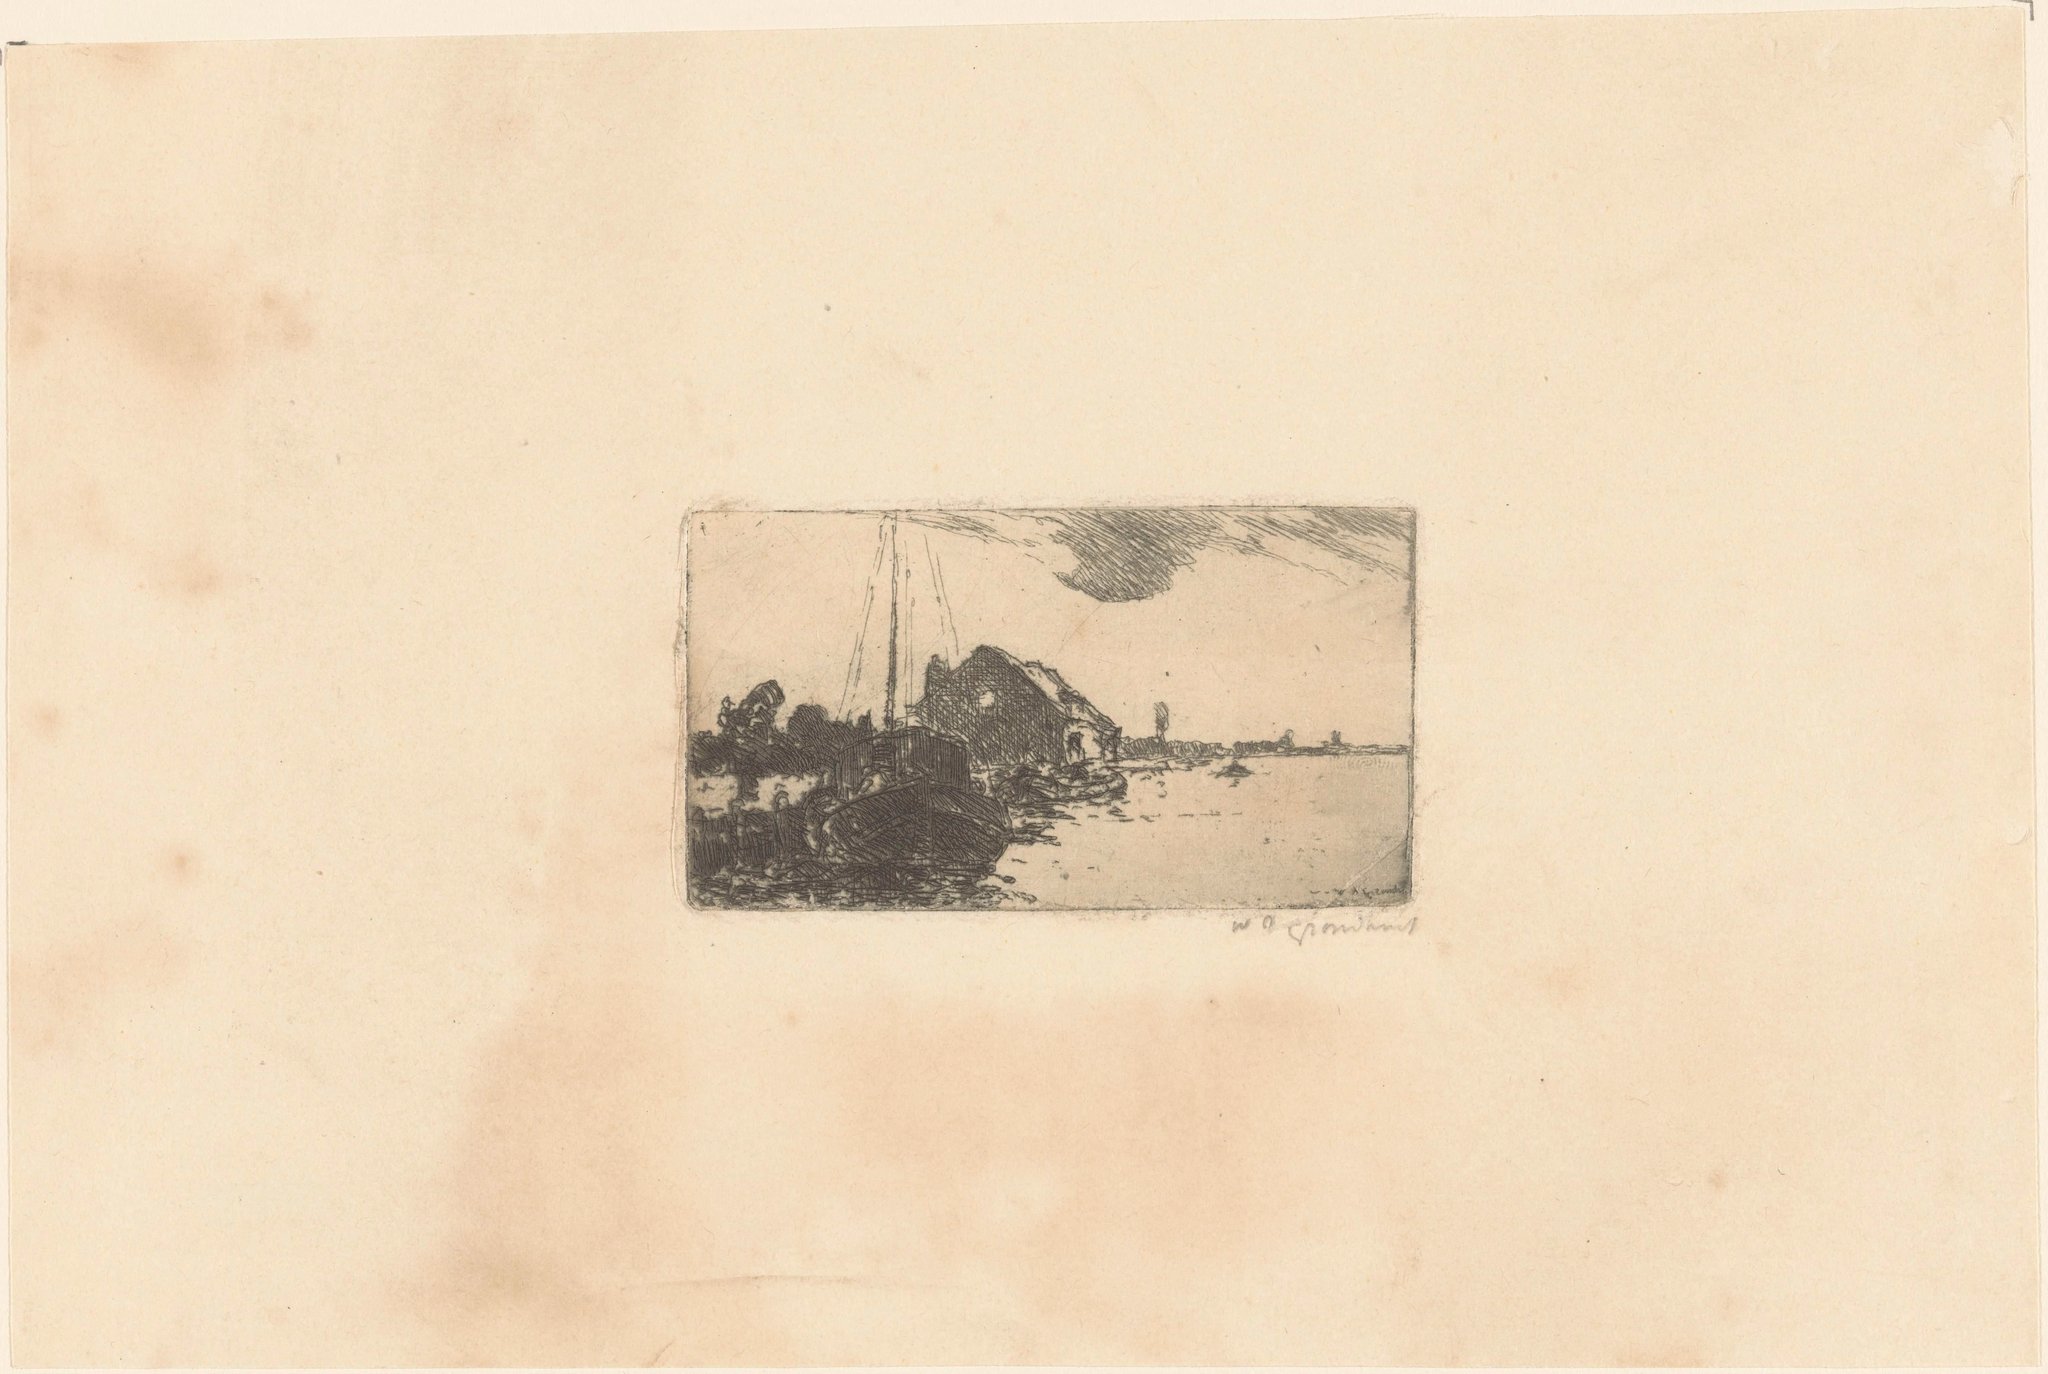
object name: print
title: Huis aan de Vliet in Voorburg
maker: willem adrianus grondhout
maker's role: draughtsman, painter, print maker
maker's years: 1878-1934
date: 1888-1934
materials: paper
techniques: etching, intaglio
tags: canal, civic architecture; edifices; dwellings, voorburg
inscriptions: collector's mark: Lugt 2228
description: Links op de voorgrond een afgemeerd schip.